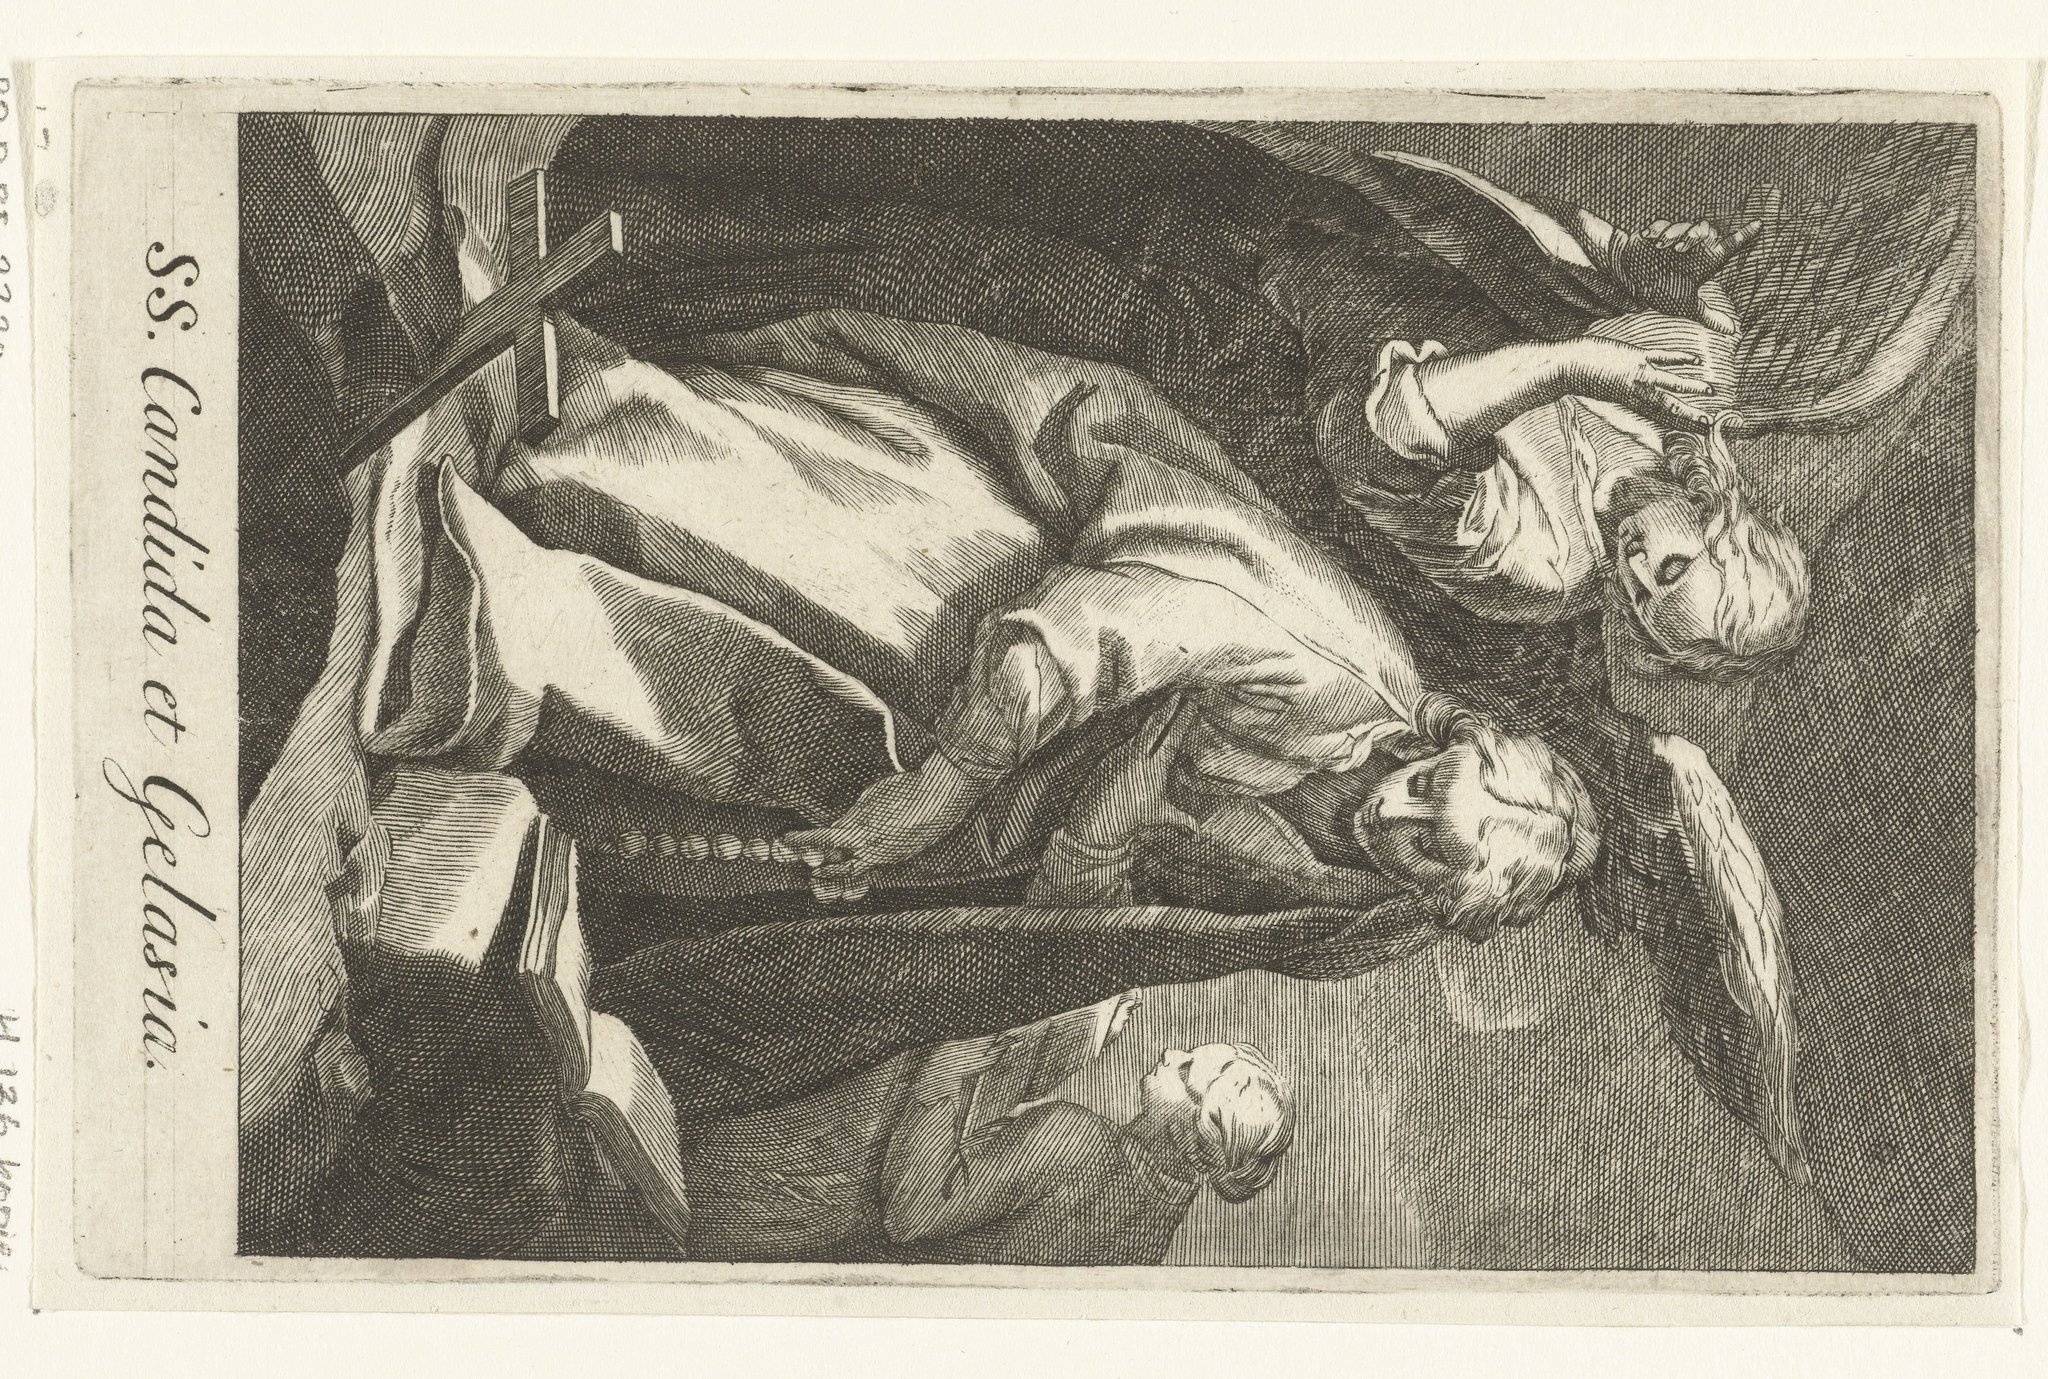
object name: print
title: Sacra Eremus Ascetriarum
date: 1590-1612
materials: paper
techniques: engraving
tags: anchorite, hermit, female saints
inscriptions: collector's mark: Lugt 2228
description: Kopie in spiegelbeeld naar prent van Boëtius Adamsz. Bolswert uit serie Kluizenaressen.